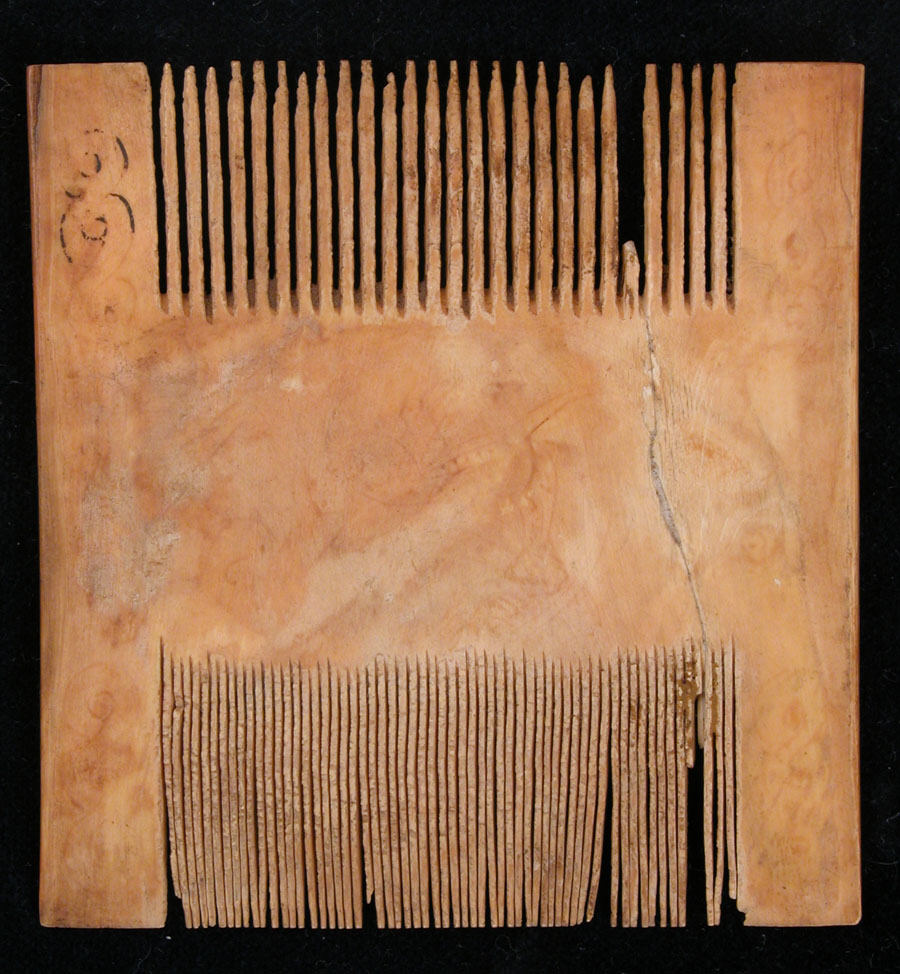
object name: comb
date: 1101-1200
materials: bone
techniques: painting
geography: italy